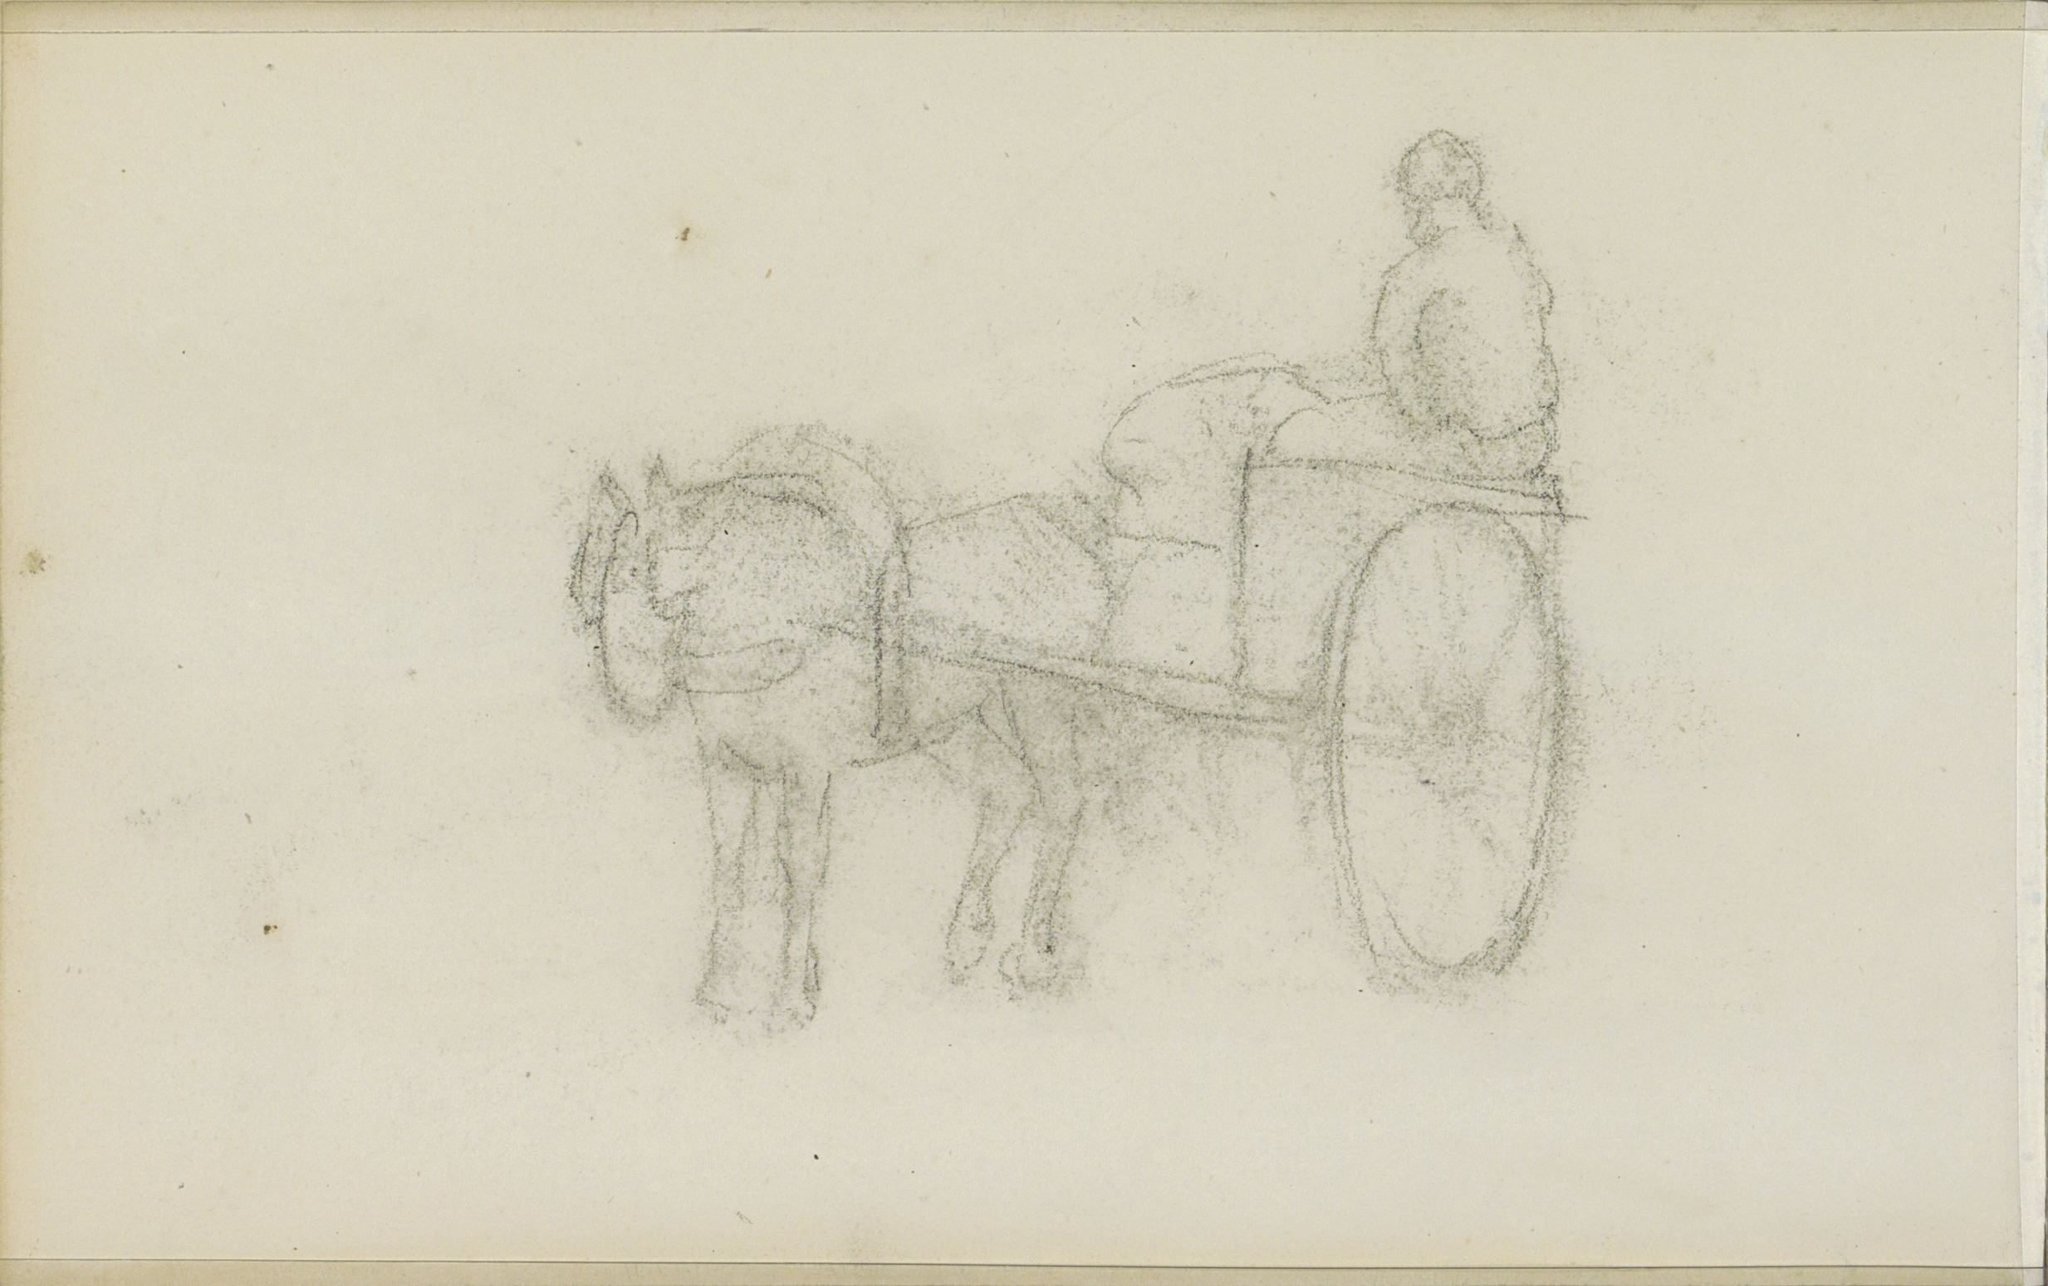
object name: sketchbook leaf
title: Zittende figuur op een paardenkar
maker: jozef israëls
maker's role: draughtsman, painter, print maker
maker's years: 1824-1911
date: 1834-1911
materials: chalk, paper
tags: sitting figure, (farm) wagon, freight wagon, cart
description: Blad 11 verso uit een schetsboek met 37 bladen.